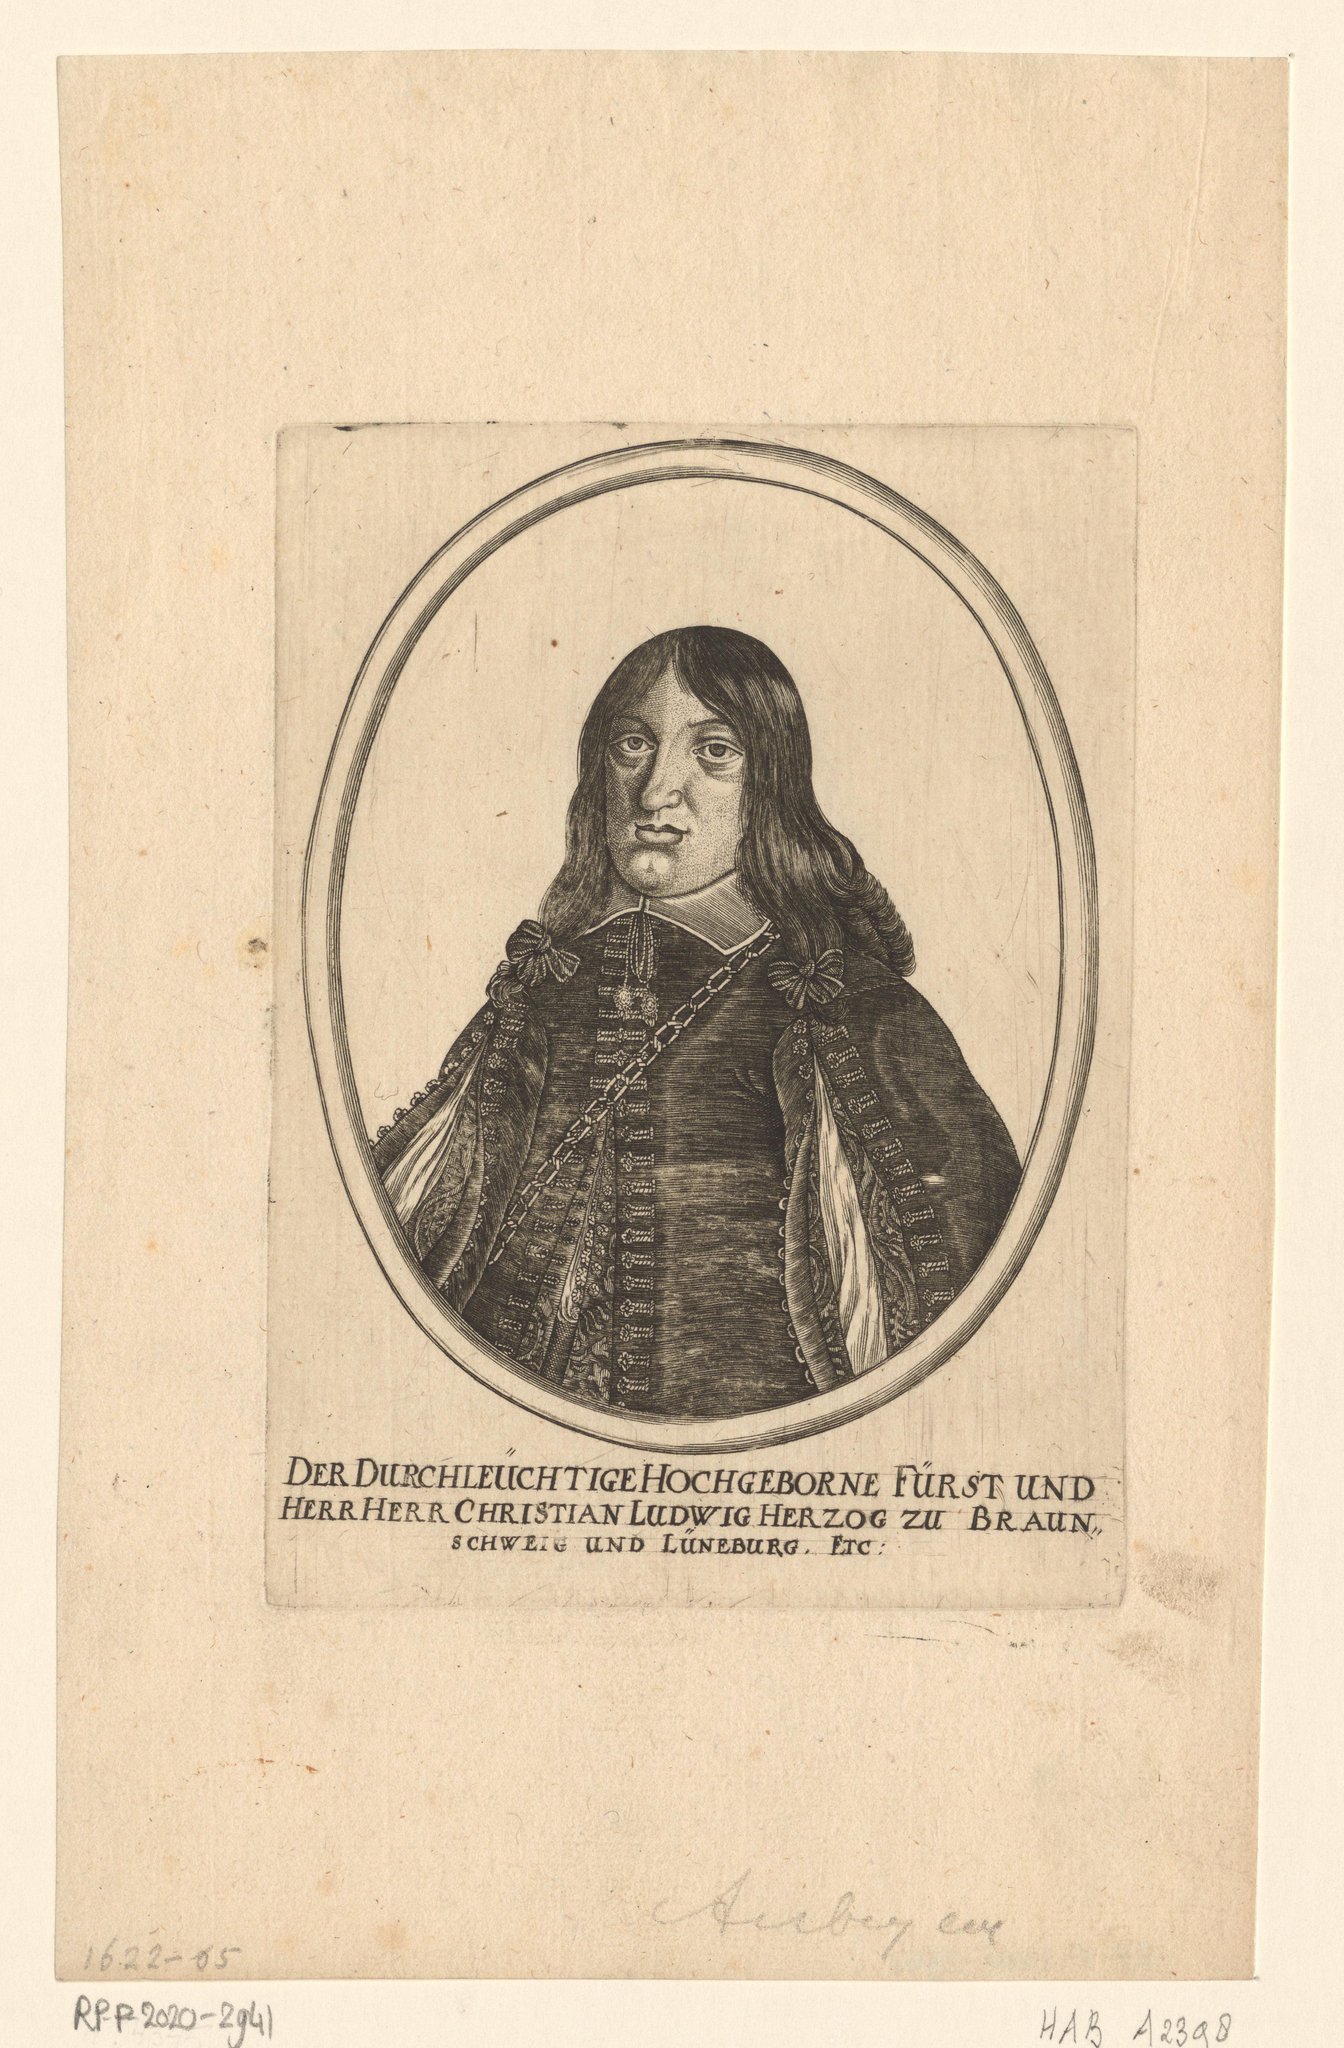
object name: print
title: Portret van Christiaan Lodewijk van Brunswijk-Lüneburg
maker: peter aubry (iii)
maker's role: print maker, publisher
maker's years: 1610-1686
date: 1642-1686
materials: paper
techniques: engraving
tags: historical persons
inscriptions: collector's mark: Lugt 2282, watermark: